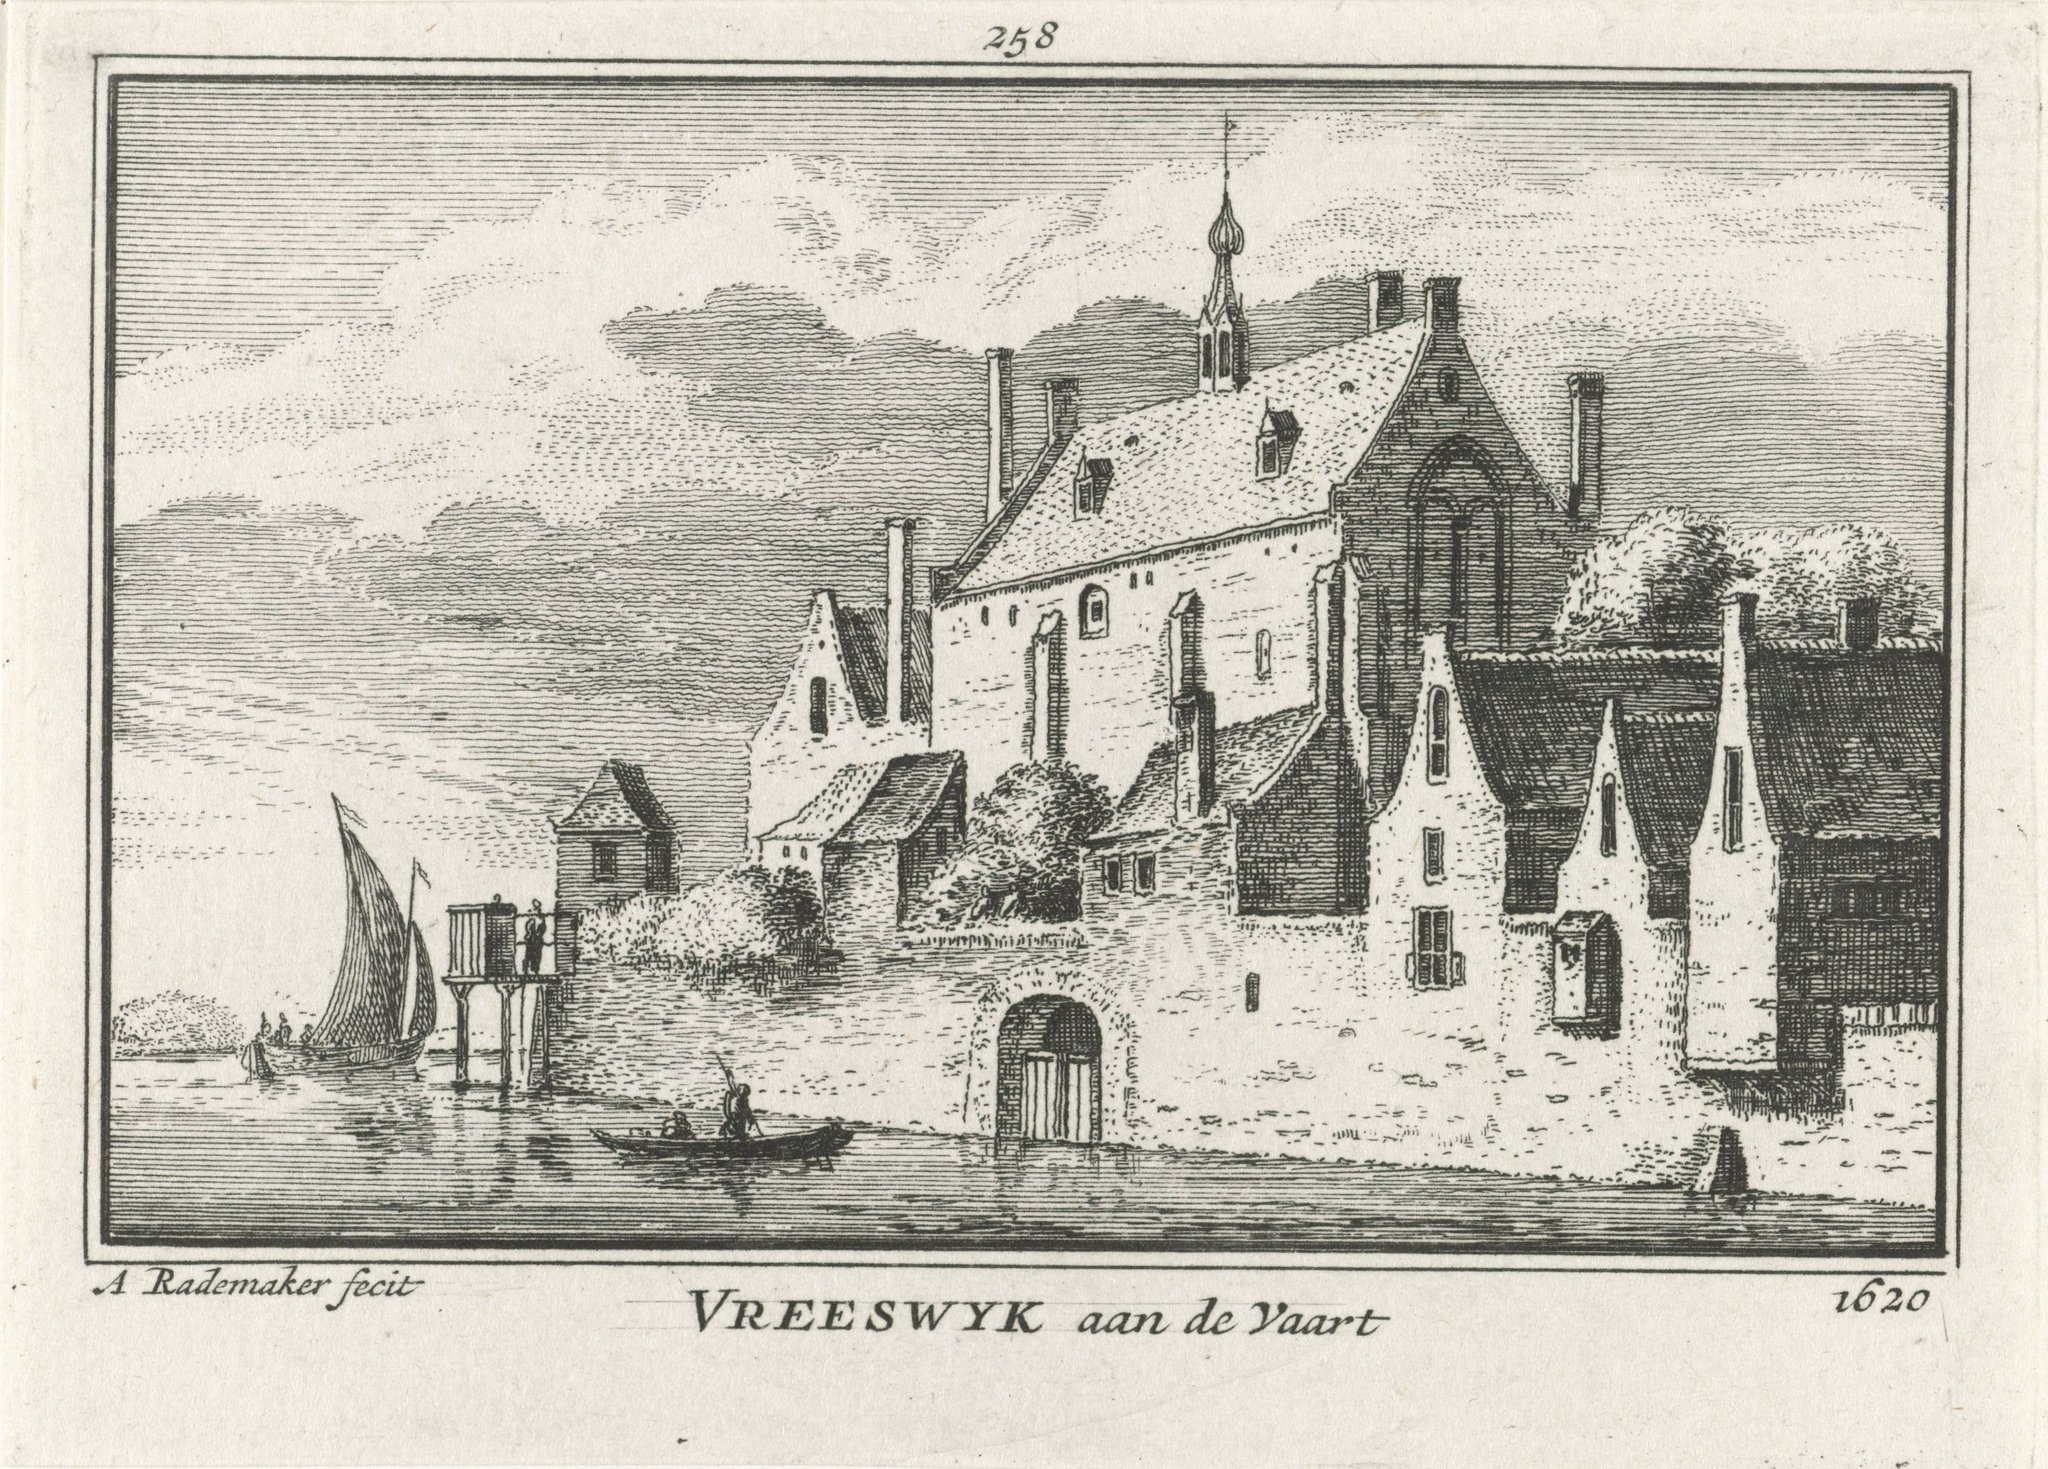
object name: print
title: Gezicht op Vreeswijk, 1620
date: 1727-1733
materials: paper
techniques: engraving, etching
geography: amsterdam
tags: church (exterior)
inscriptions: collector's mark: Lugt 2228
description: Illustratie uit: Abraham Rademaker, Matthaeus Brouërius van Niedek, Isaac Le Long, Kabinet van Nederlandsche en Kleefsche outheden en (...) voorname stads- en landgebouwen, Willem Barents en Antoni Schoonenburg: Amsterdam, 1727-1733, ill. nr. 258.